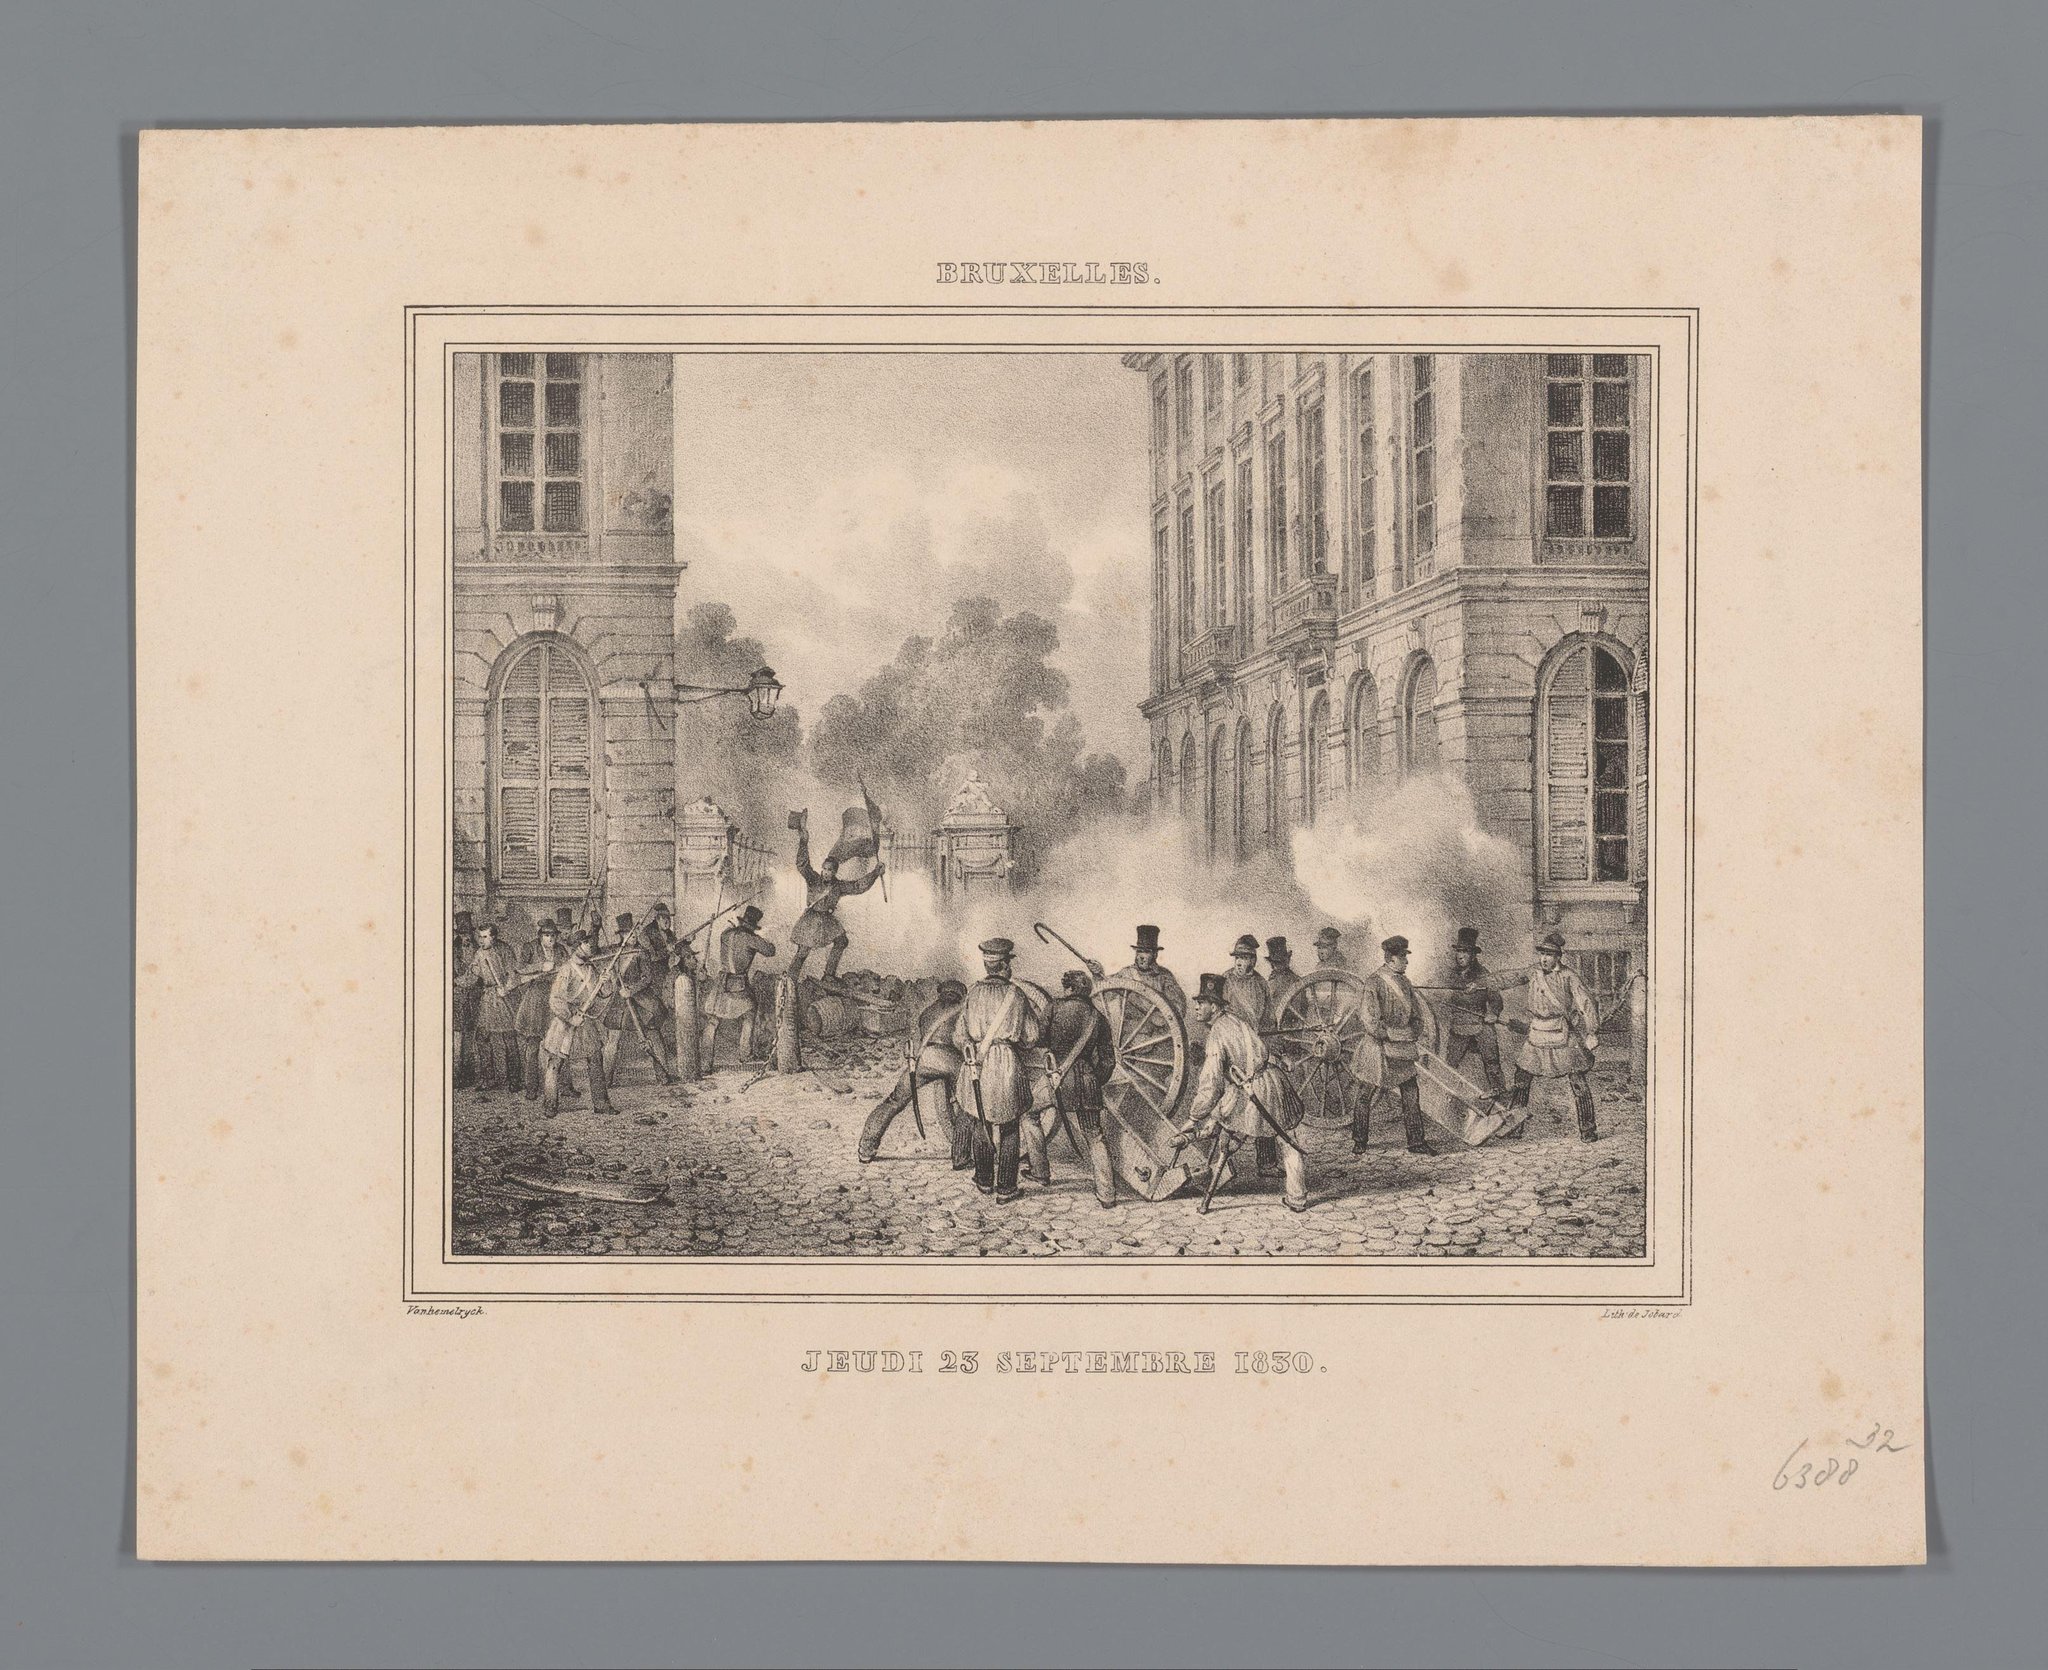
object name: print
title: Evénemens de la Belgique Dessinés sur les lieux par des témoins oculaires, Bruxelles, à la Lithographie de Jobard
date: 1830-1831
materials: paper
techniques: lithograph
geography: brussels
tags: barricades ~ riot, brussels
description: Onderdeel van een groep van prenten uit verschillende andere series verwant aan de platen in het recueil over de gebeurtenissen tijdens de Belgische Revolutie in Brussel, Antwerpen en andere steden in de periode 25 augustus 1830 tot 27 maart 1831. Uitgegeven in de serie van 23 prenten getiteld: Evénemens de la Belgique Dessinés sur les lieux par des témoins oculaires, Bruxelles, à la Lithographie de Jobard, éditeur, [1831].